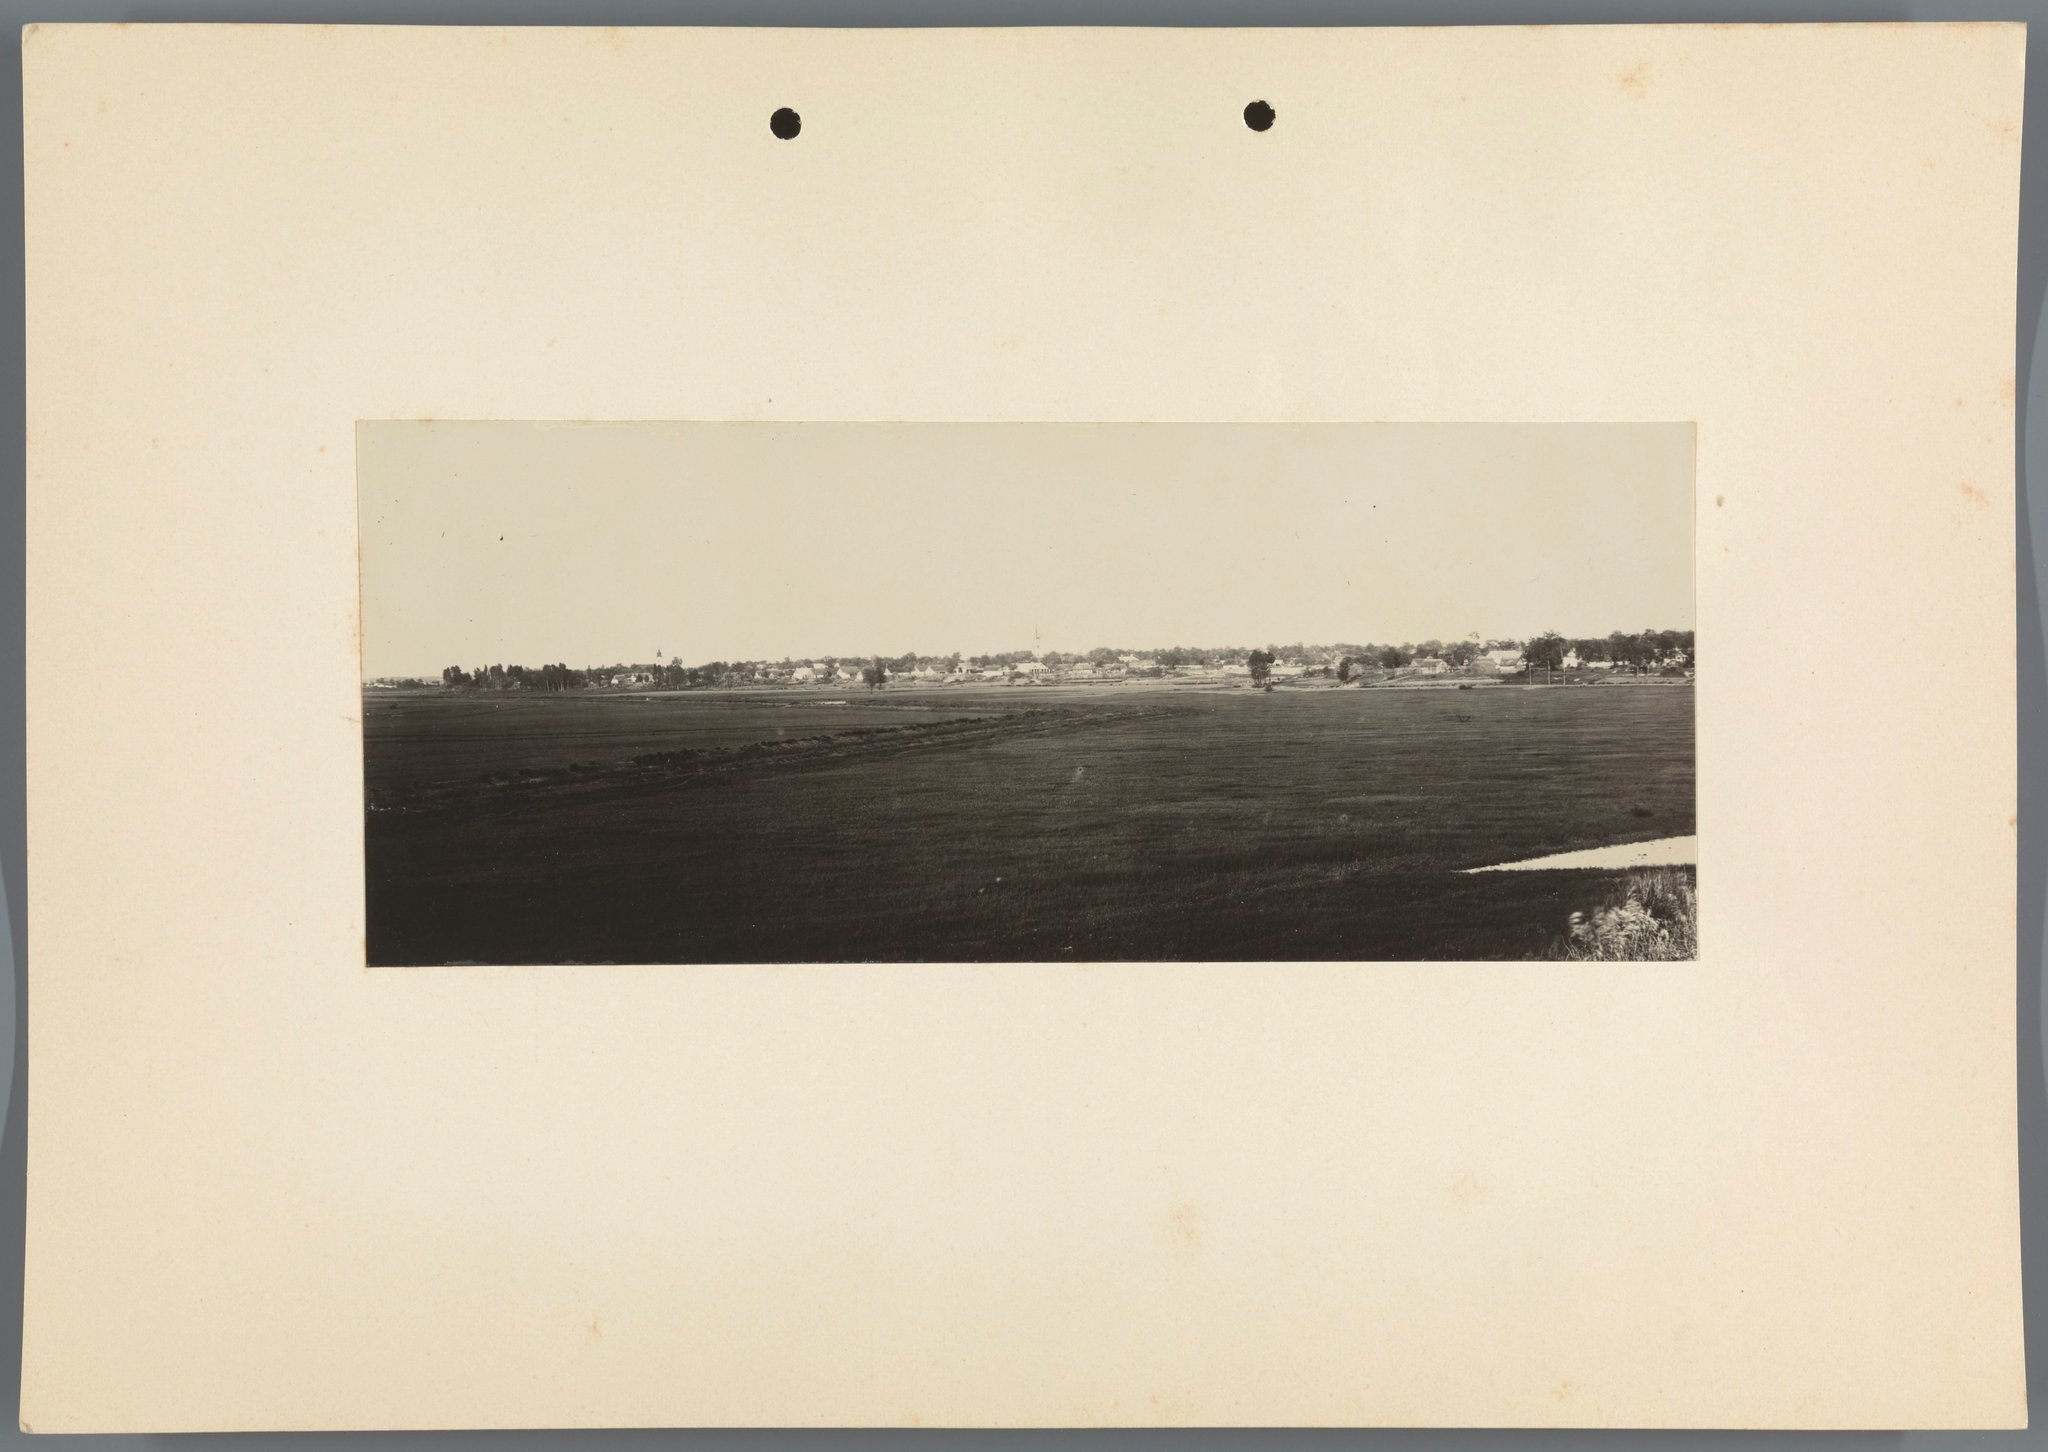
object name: photograph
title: Gezicht op Tószeg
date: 1928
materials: paper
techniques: gelatin silver print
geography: hungary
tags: prospect of village, silhouette of village